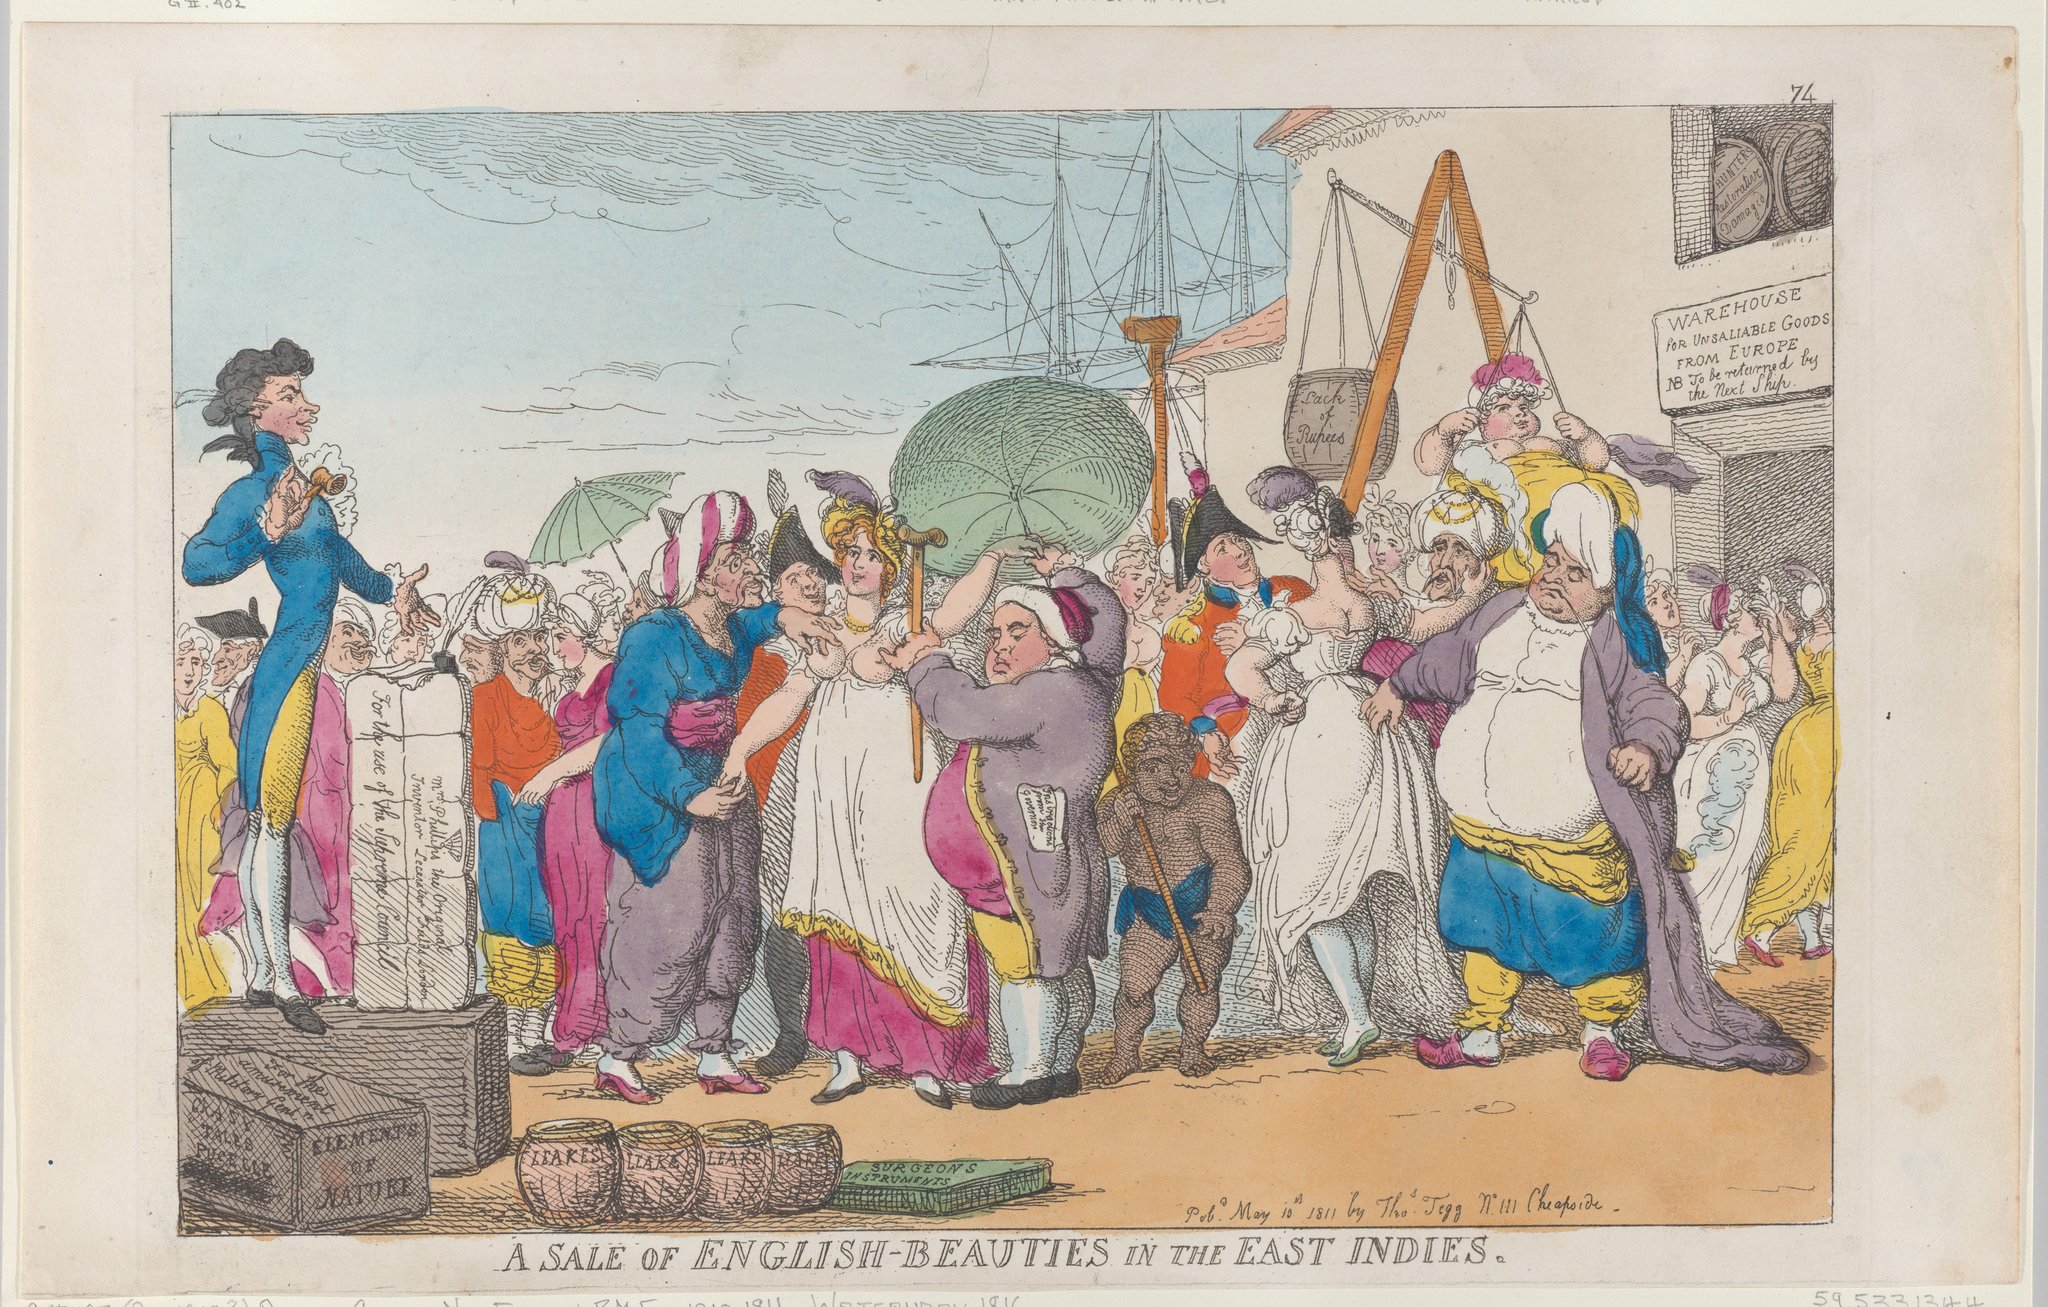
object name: print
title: A Sale of English-Beauties in the East Indies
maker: thomas rowlandson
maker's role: artist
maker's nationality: british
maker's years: 1757-1827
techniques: etching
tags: satire,men,women